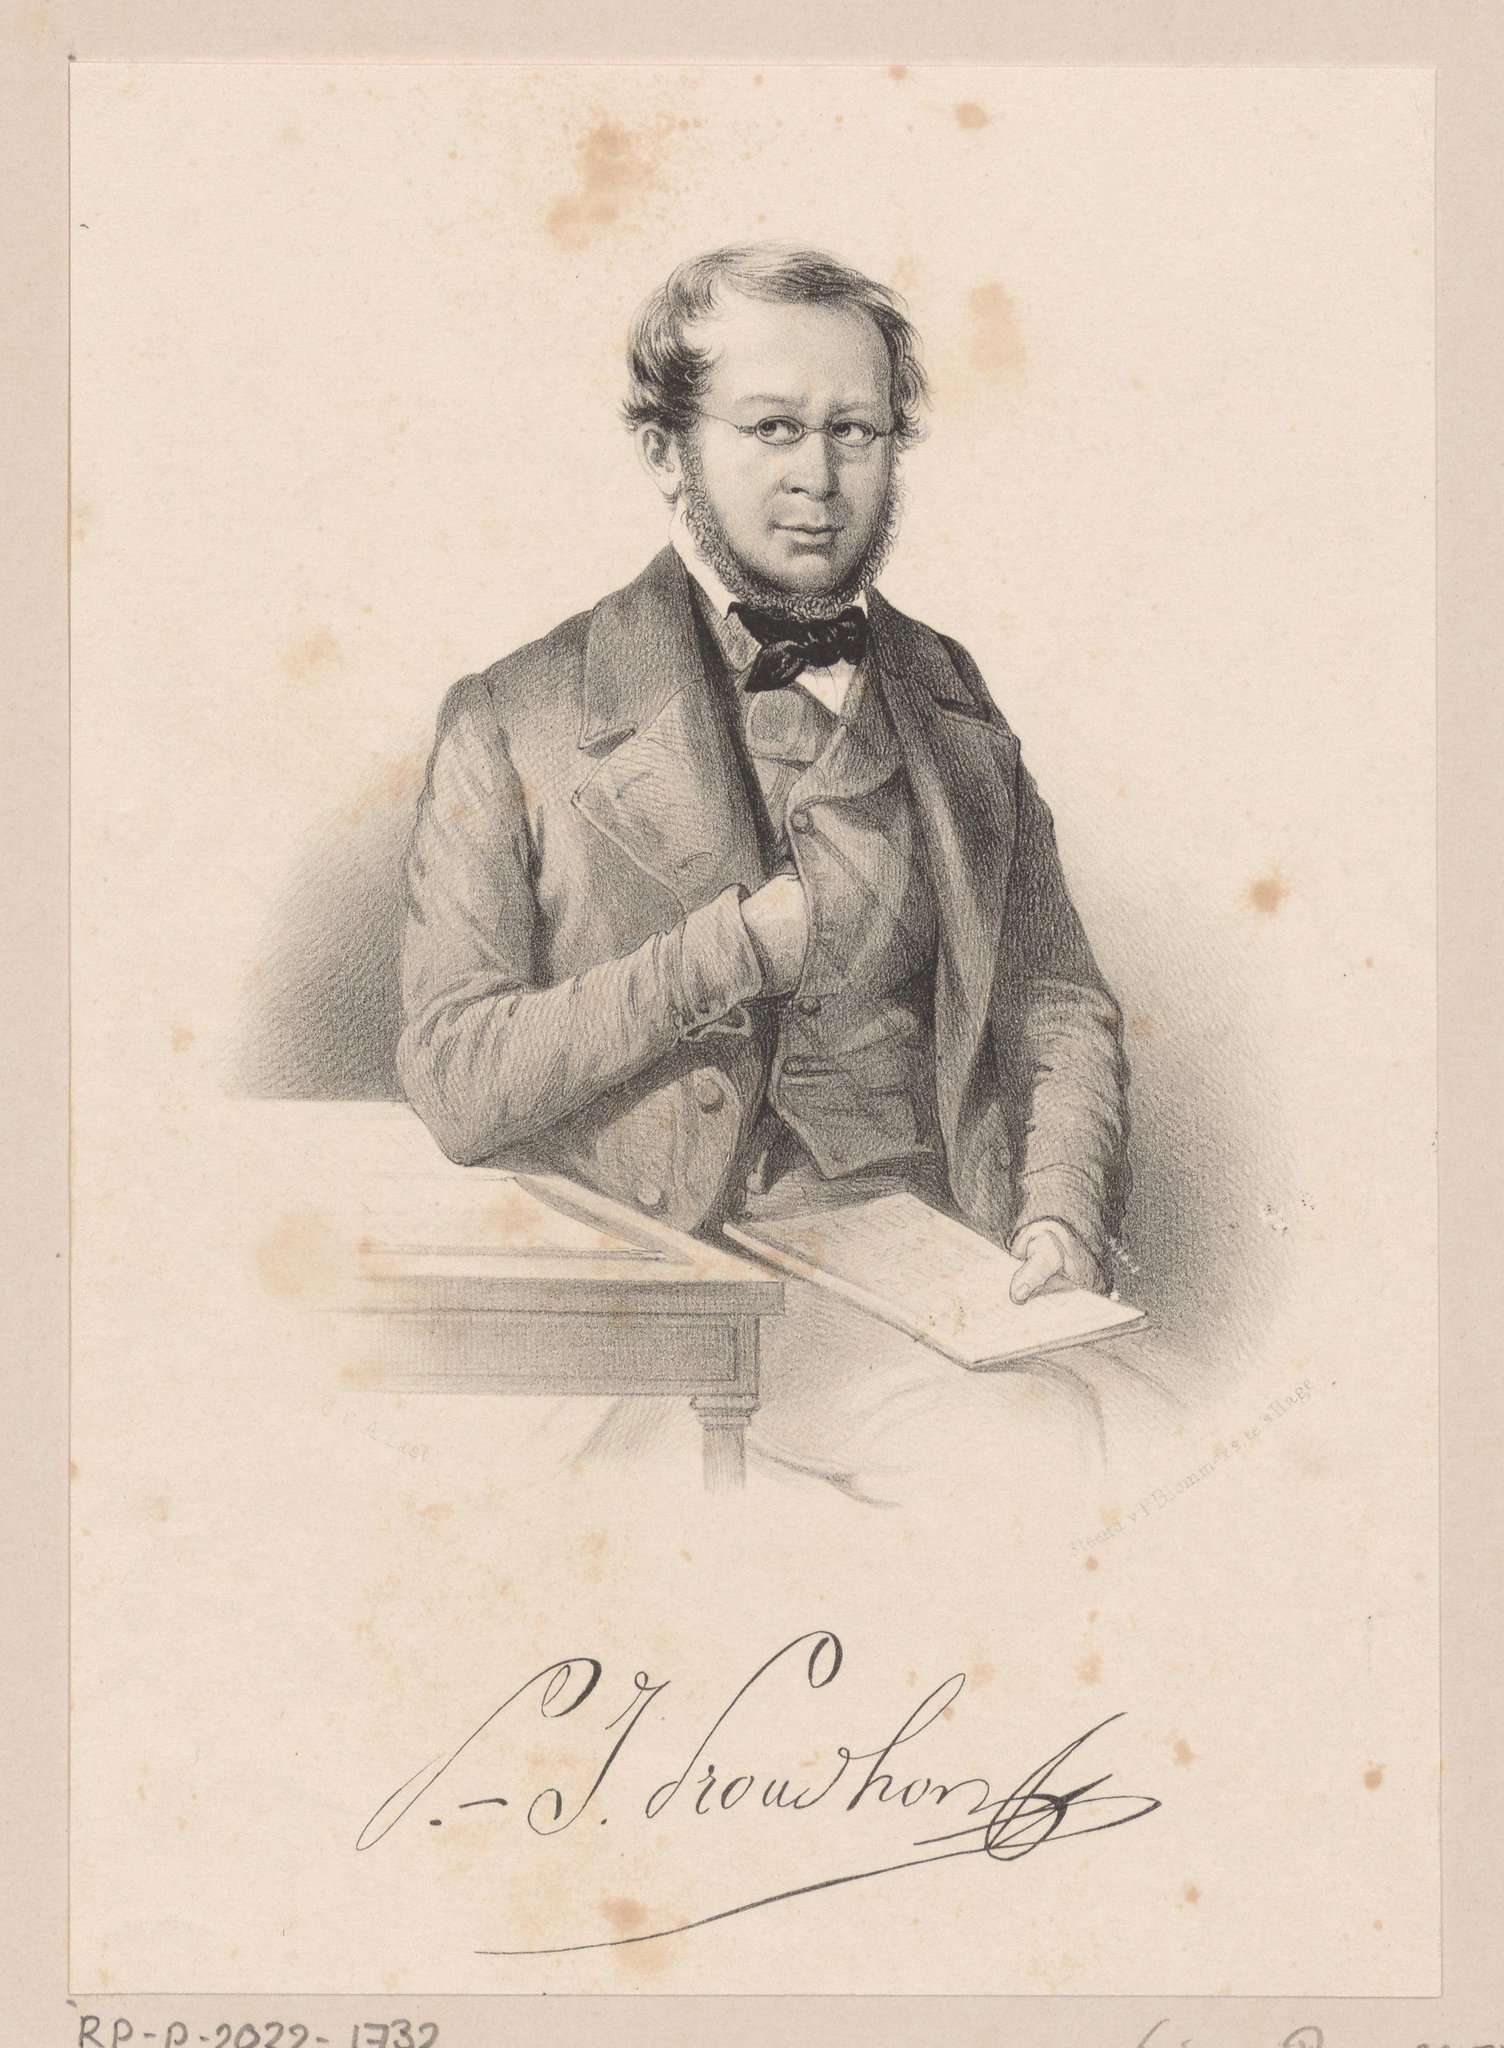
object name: print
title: Portret van Pierre-Joseph Proudhon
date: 1842-1876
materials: paper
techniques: lithograph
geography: the hague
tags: paris, eyeglasses, spectacles, historical persons